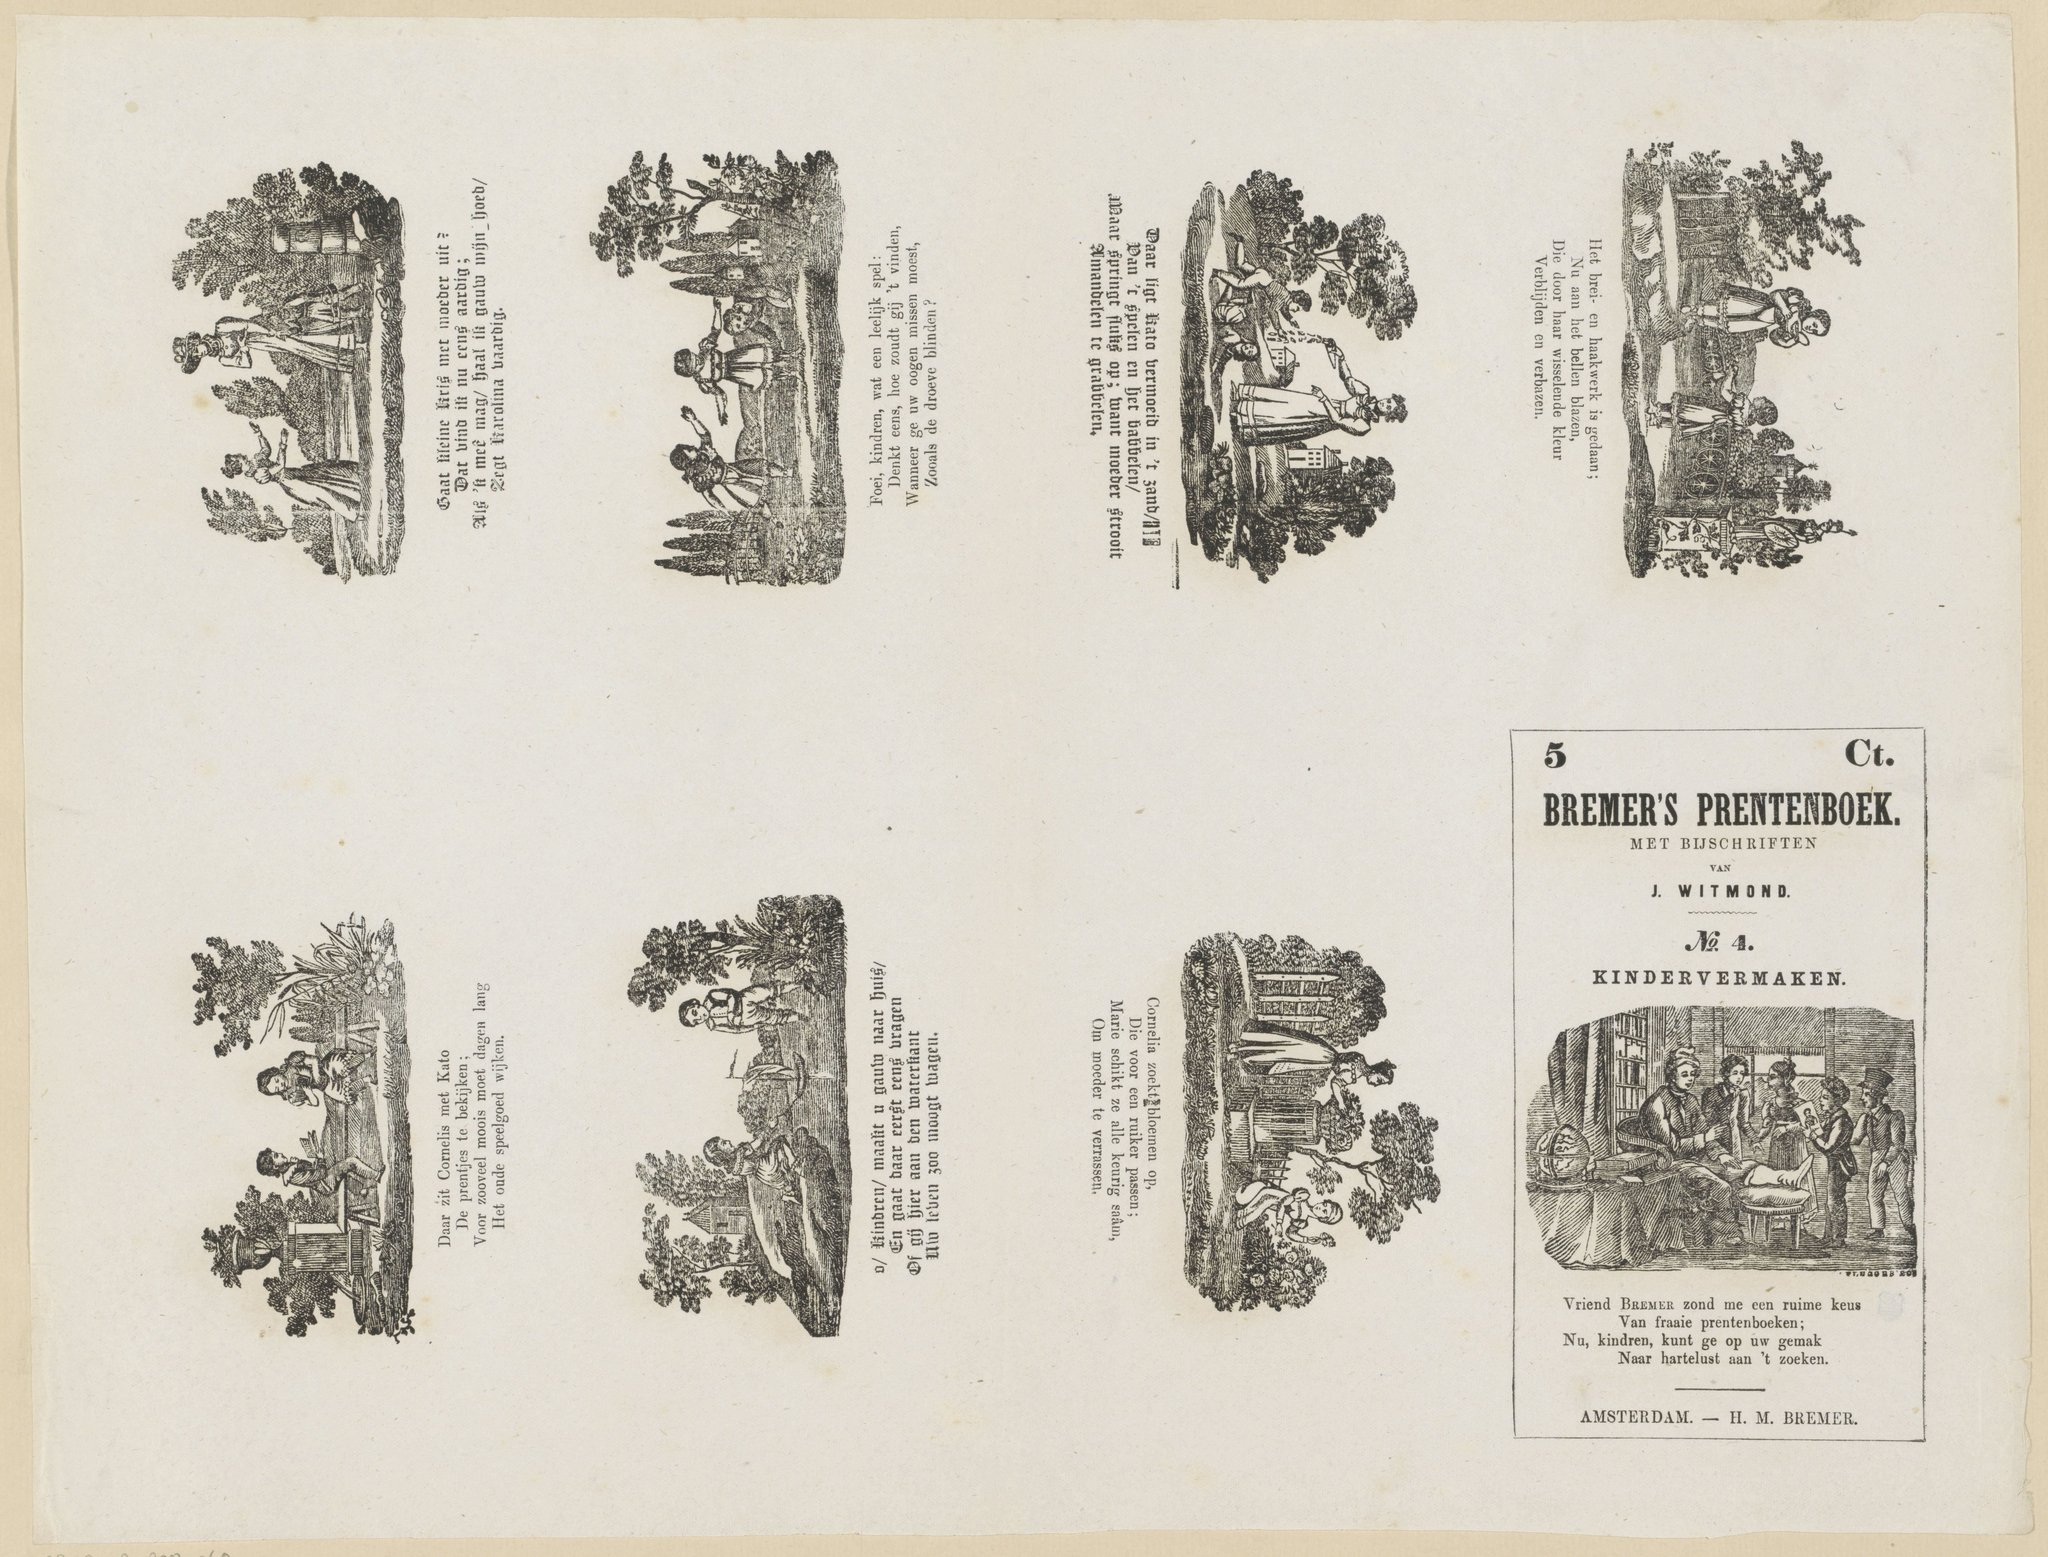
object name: print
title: Bremer's prentenboek. / met bijschriften / van / J. Witmond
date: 1867-1883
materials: paper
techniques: letterpress printing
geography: amsterdam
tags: bubble-blowing (children's games and plays), children's games and plays, reading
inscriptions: collector's mark: Lugt 2760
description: Blad met 7 voorstellingen van bezigheden voor kinderen, zoals lezen, bloemen plukken en bellenblazen. Onder elke voorstelling een vierregelig vers, sommige in gotisch schrift. Rechtsonder een blok met titels en uitgeversadres en een voorstelling van een vader en zijn kinderen in een interieur. Genummerd onder titel: No. 4.